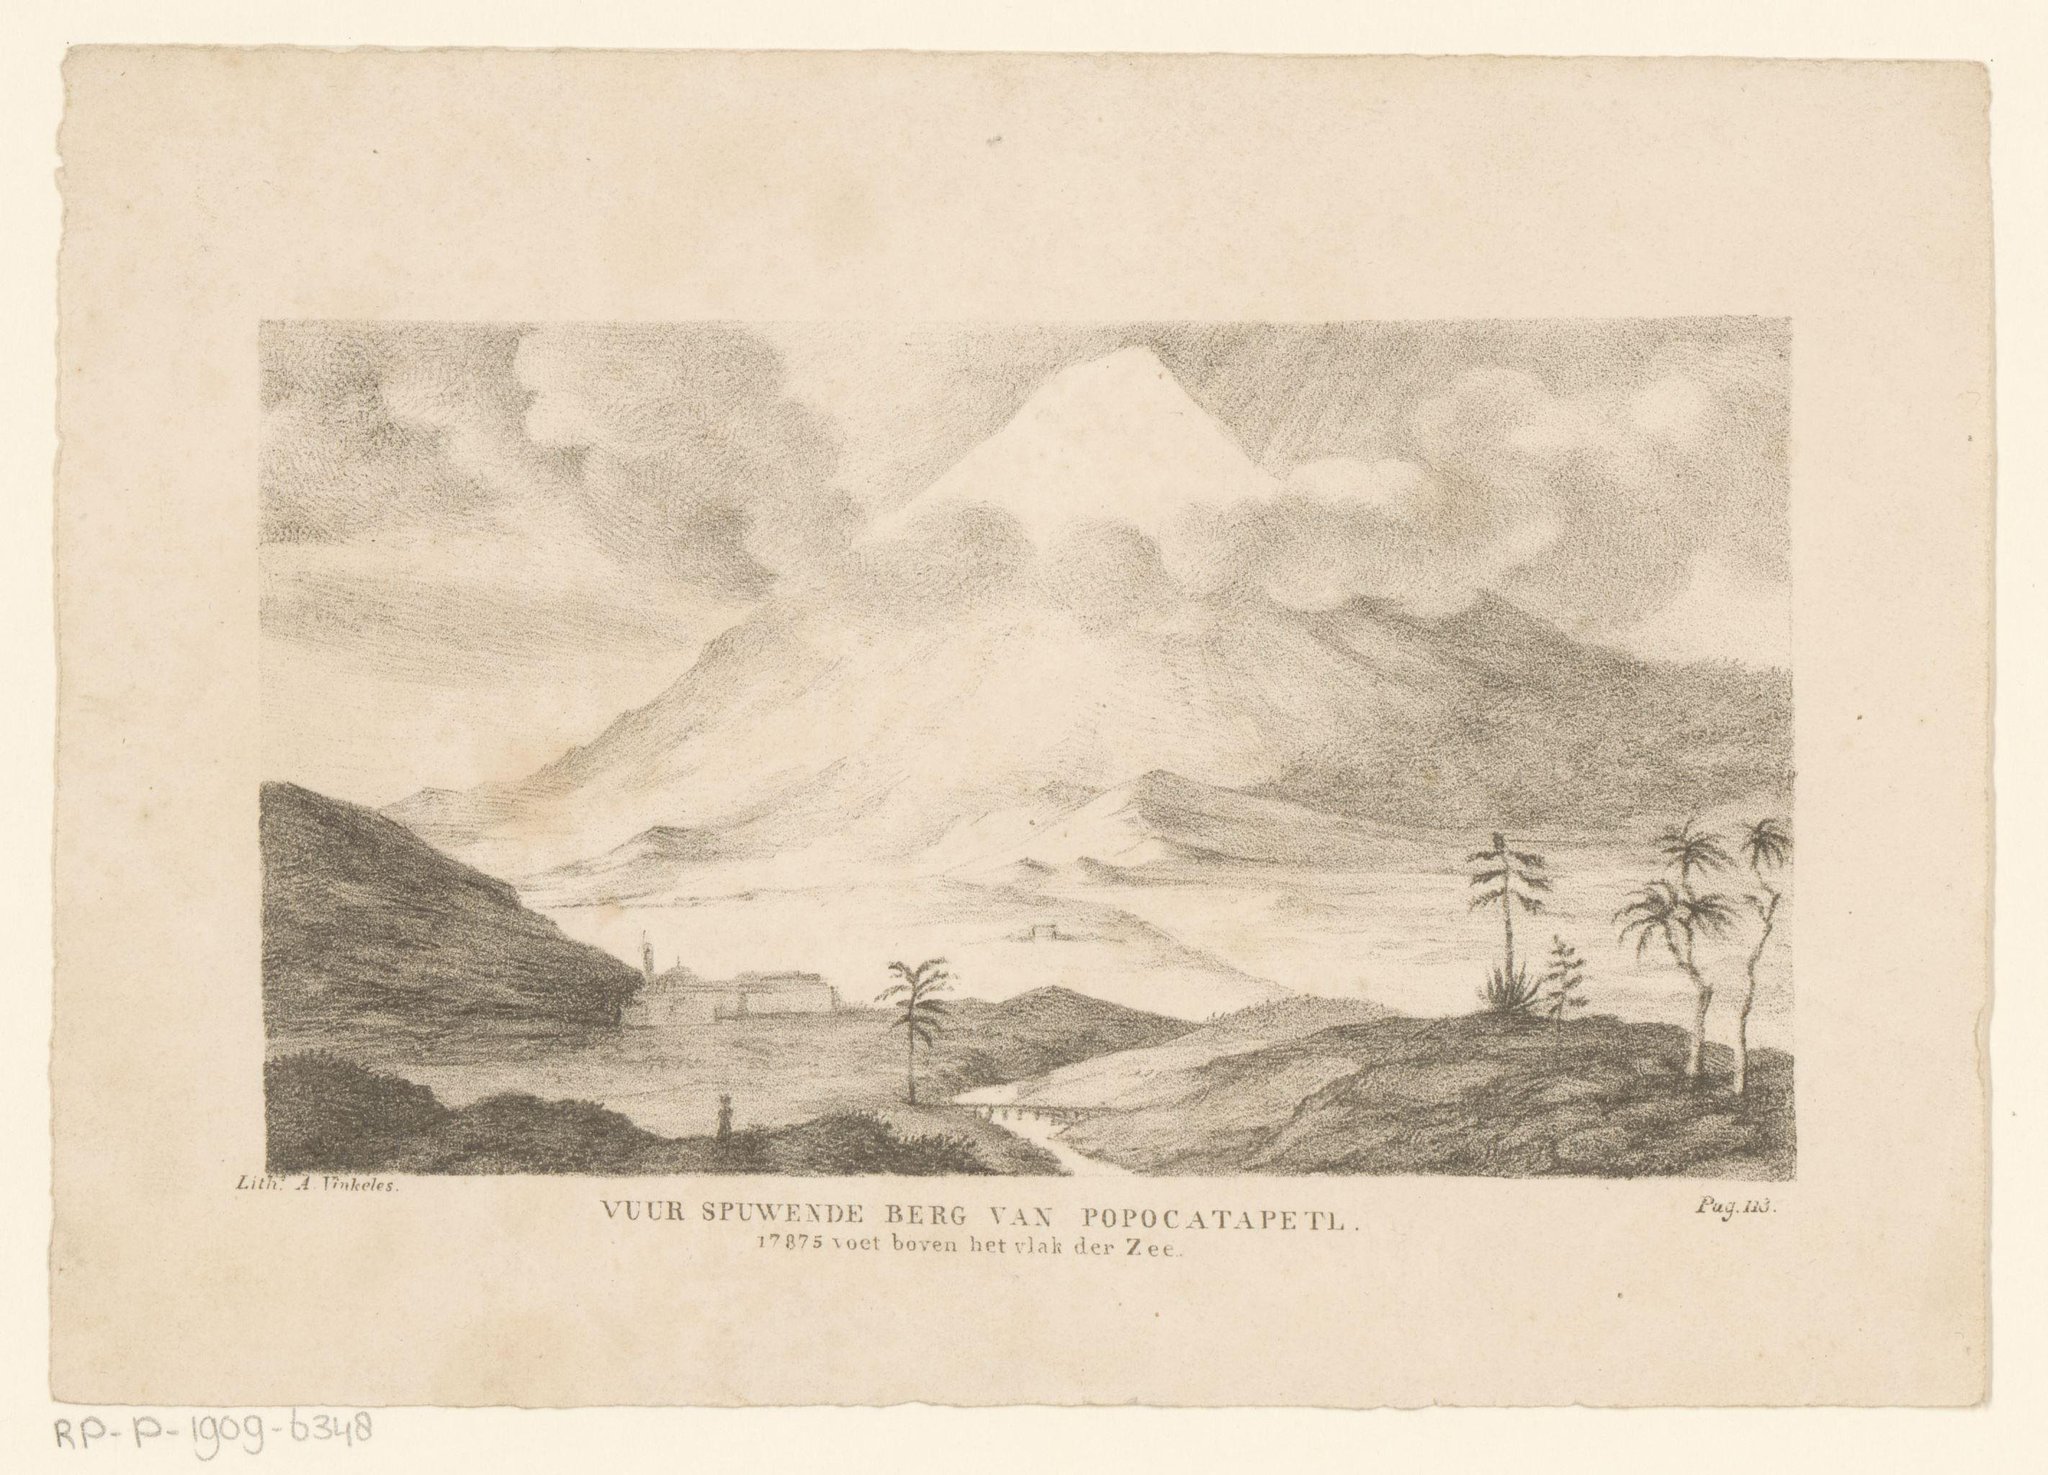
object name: print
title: Vuur spuwende berg van Popocatapetl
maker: abraham vinkeles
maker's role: draughtsman, print maker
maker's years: 1790-1864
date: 1825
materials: paper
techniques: lithograph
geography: netherlands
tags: volcano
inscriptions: collector's mark: Lugt 2228